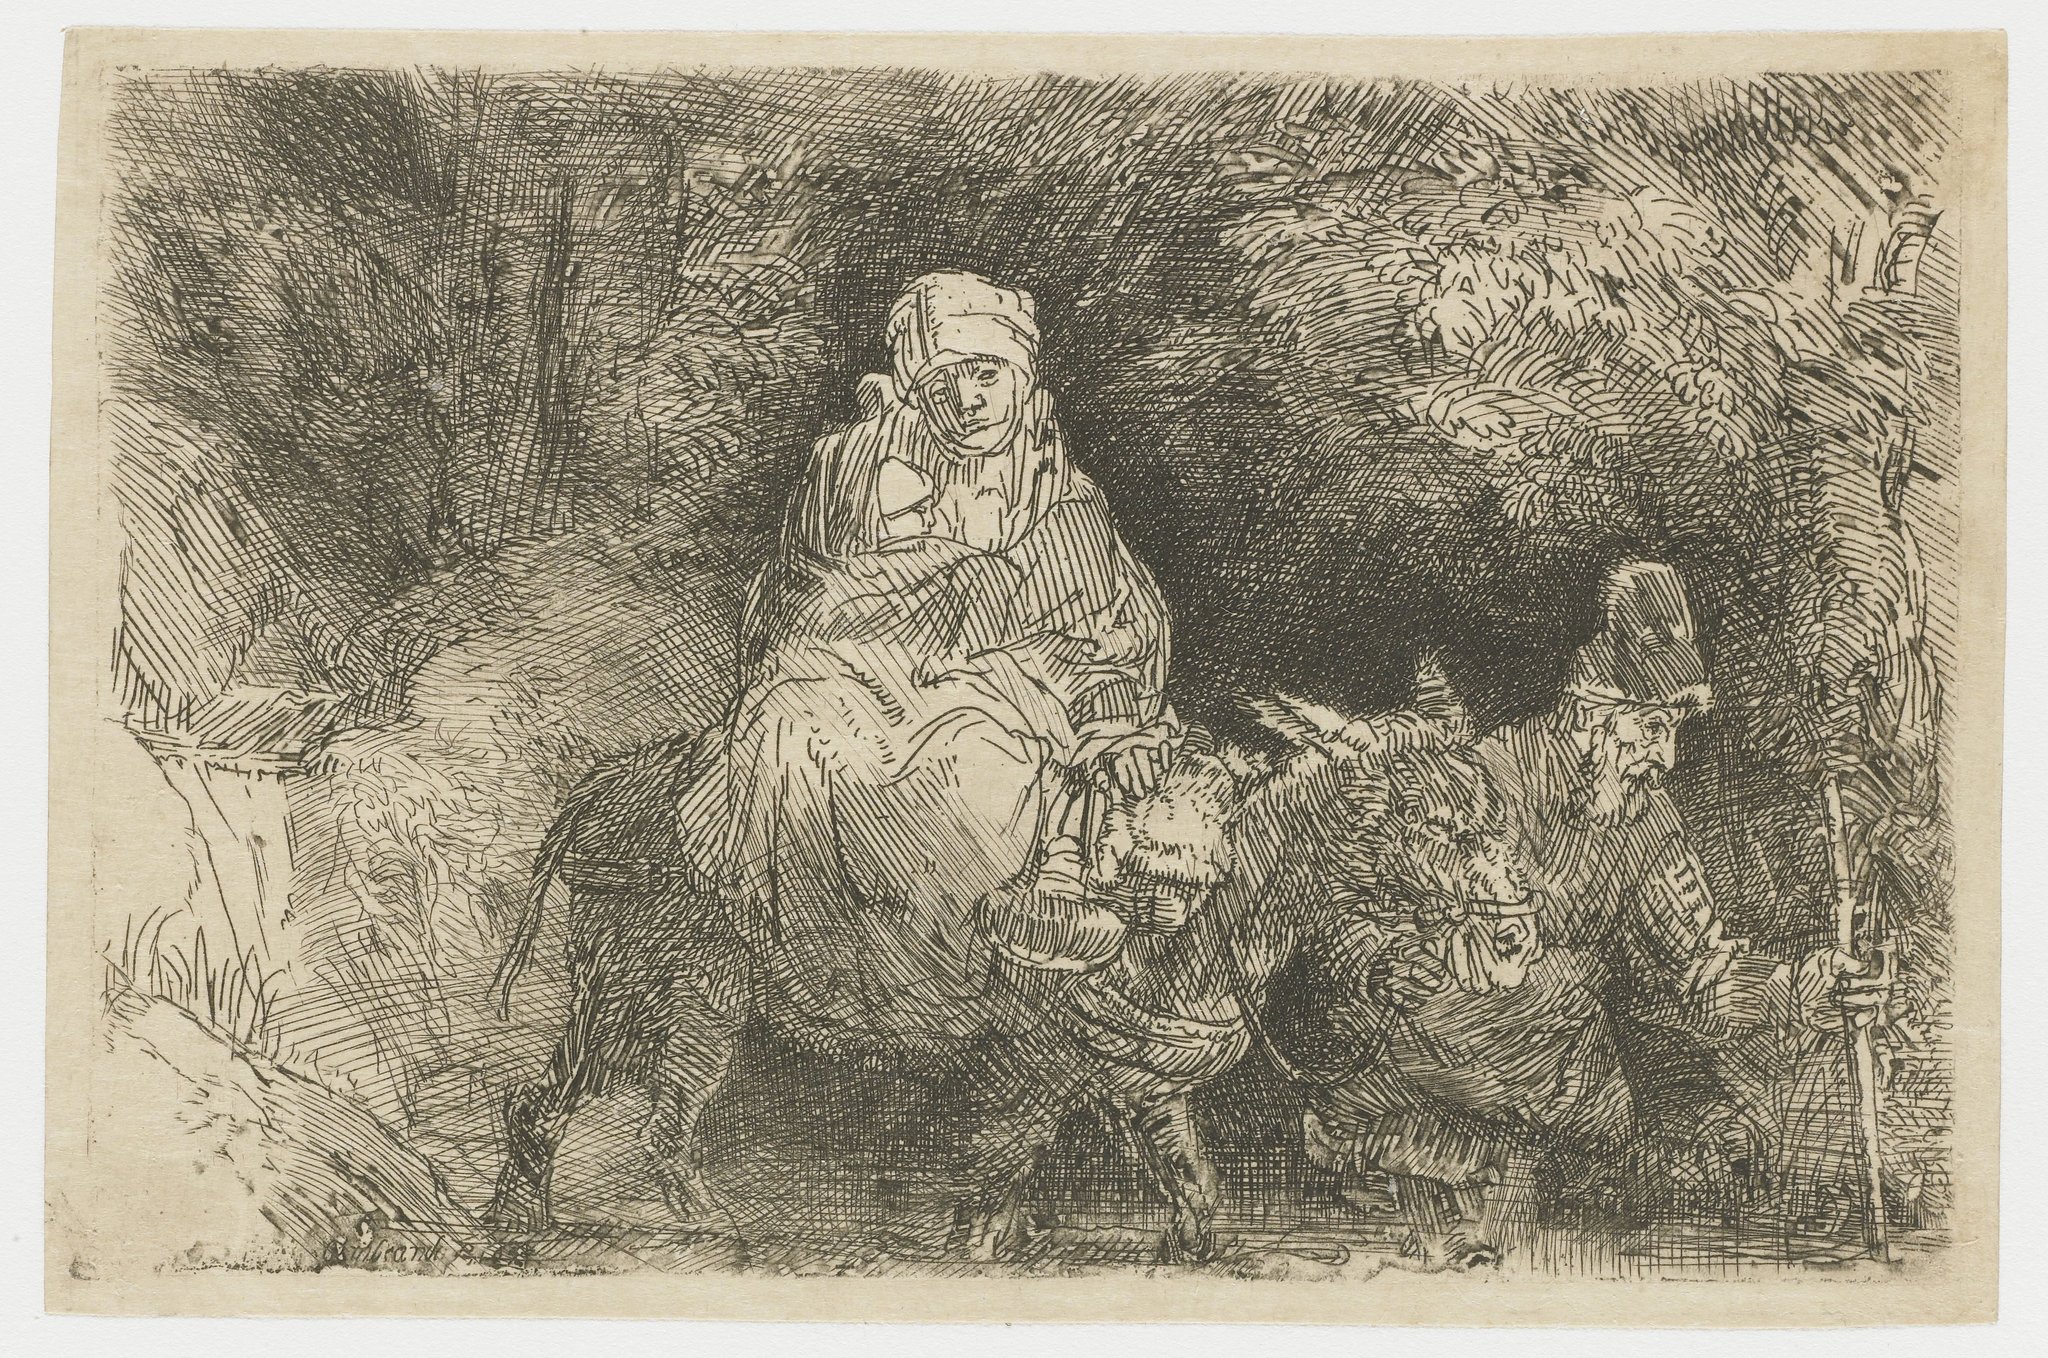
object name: print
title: The flight into Egypt crossing a brook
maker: rembrandt van rijn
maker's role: draughtsman, painter, print maker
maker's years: 1606-1669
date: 1654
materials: paper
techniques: drypoint, etching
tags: the flight into egypt: mary, joseph, the child (and sometimes others) on their way; mary usually riding on an ass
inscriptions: collector's mark: Lugt 2228, inscription: ‘R. Wilson - landscape painter 1754 (met monogran RA)’, collector's mark: Lugt 1336, signature and date: ‘Rembrandt f. 1654’